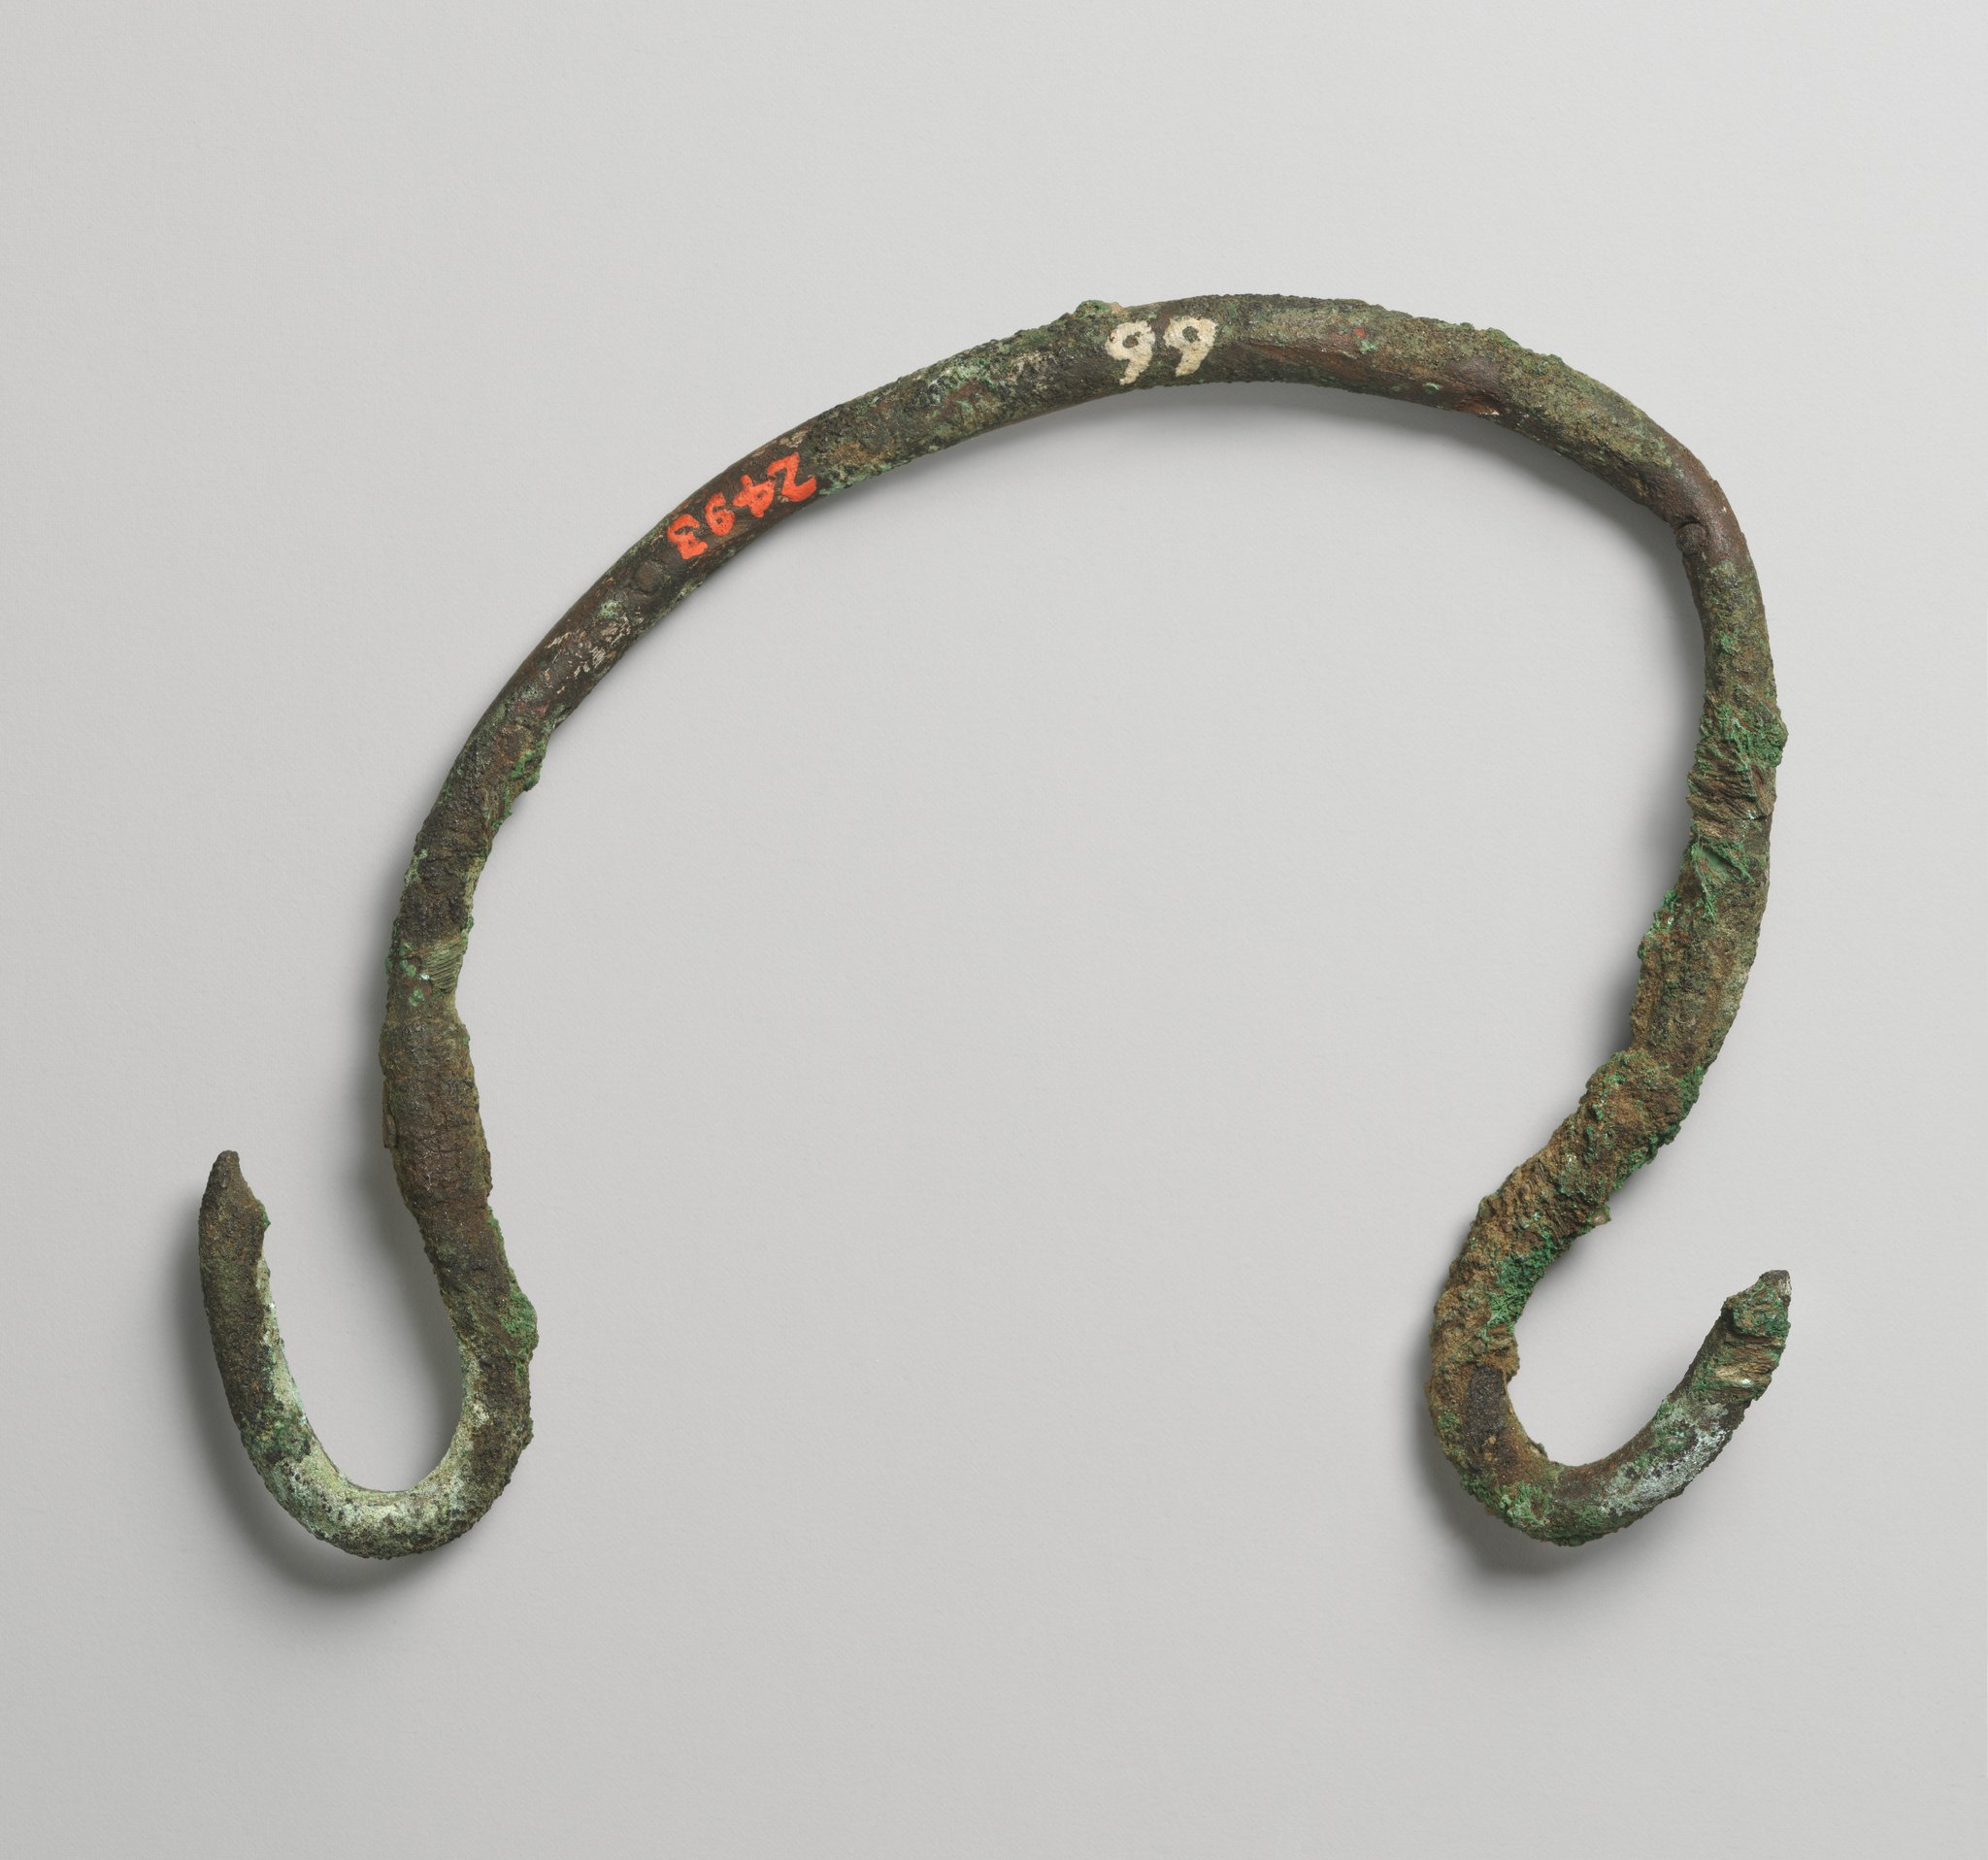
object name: vase handle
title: Handle from metal vase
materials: bronze, copper alloy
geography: egypt